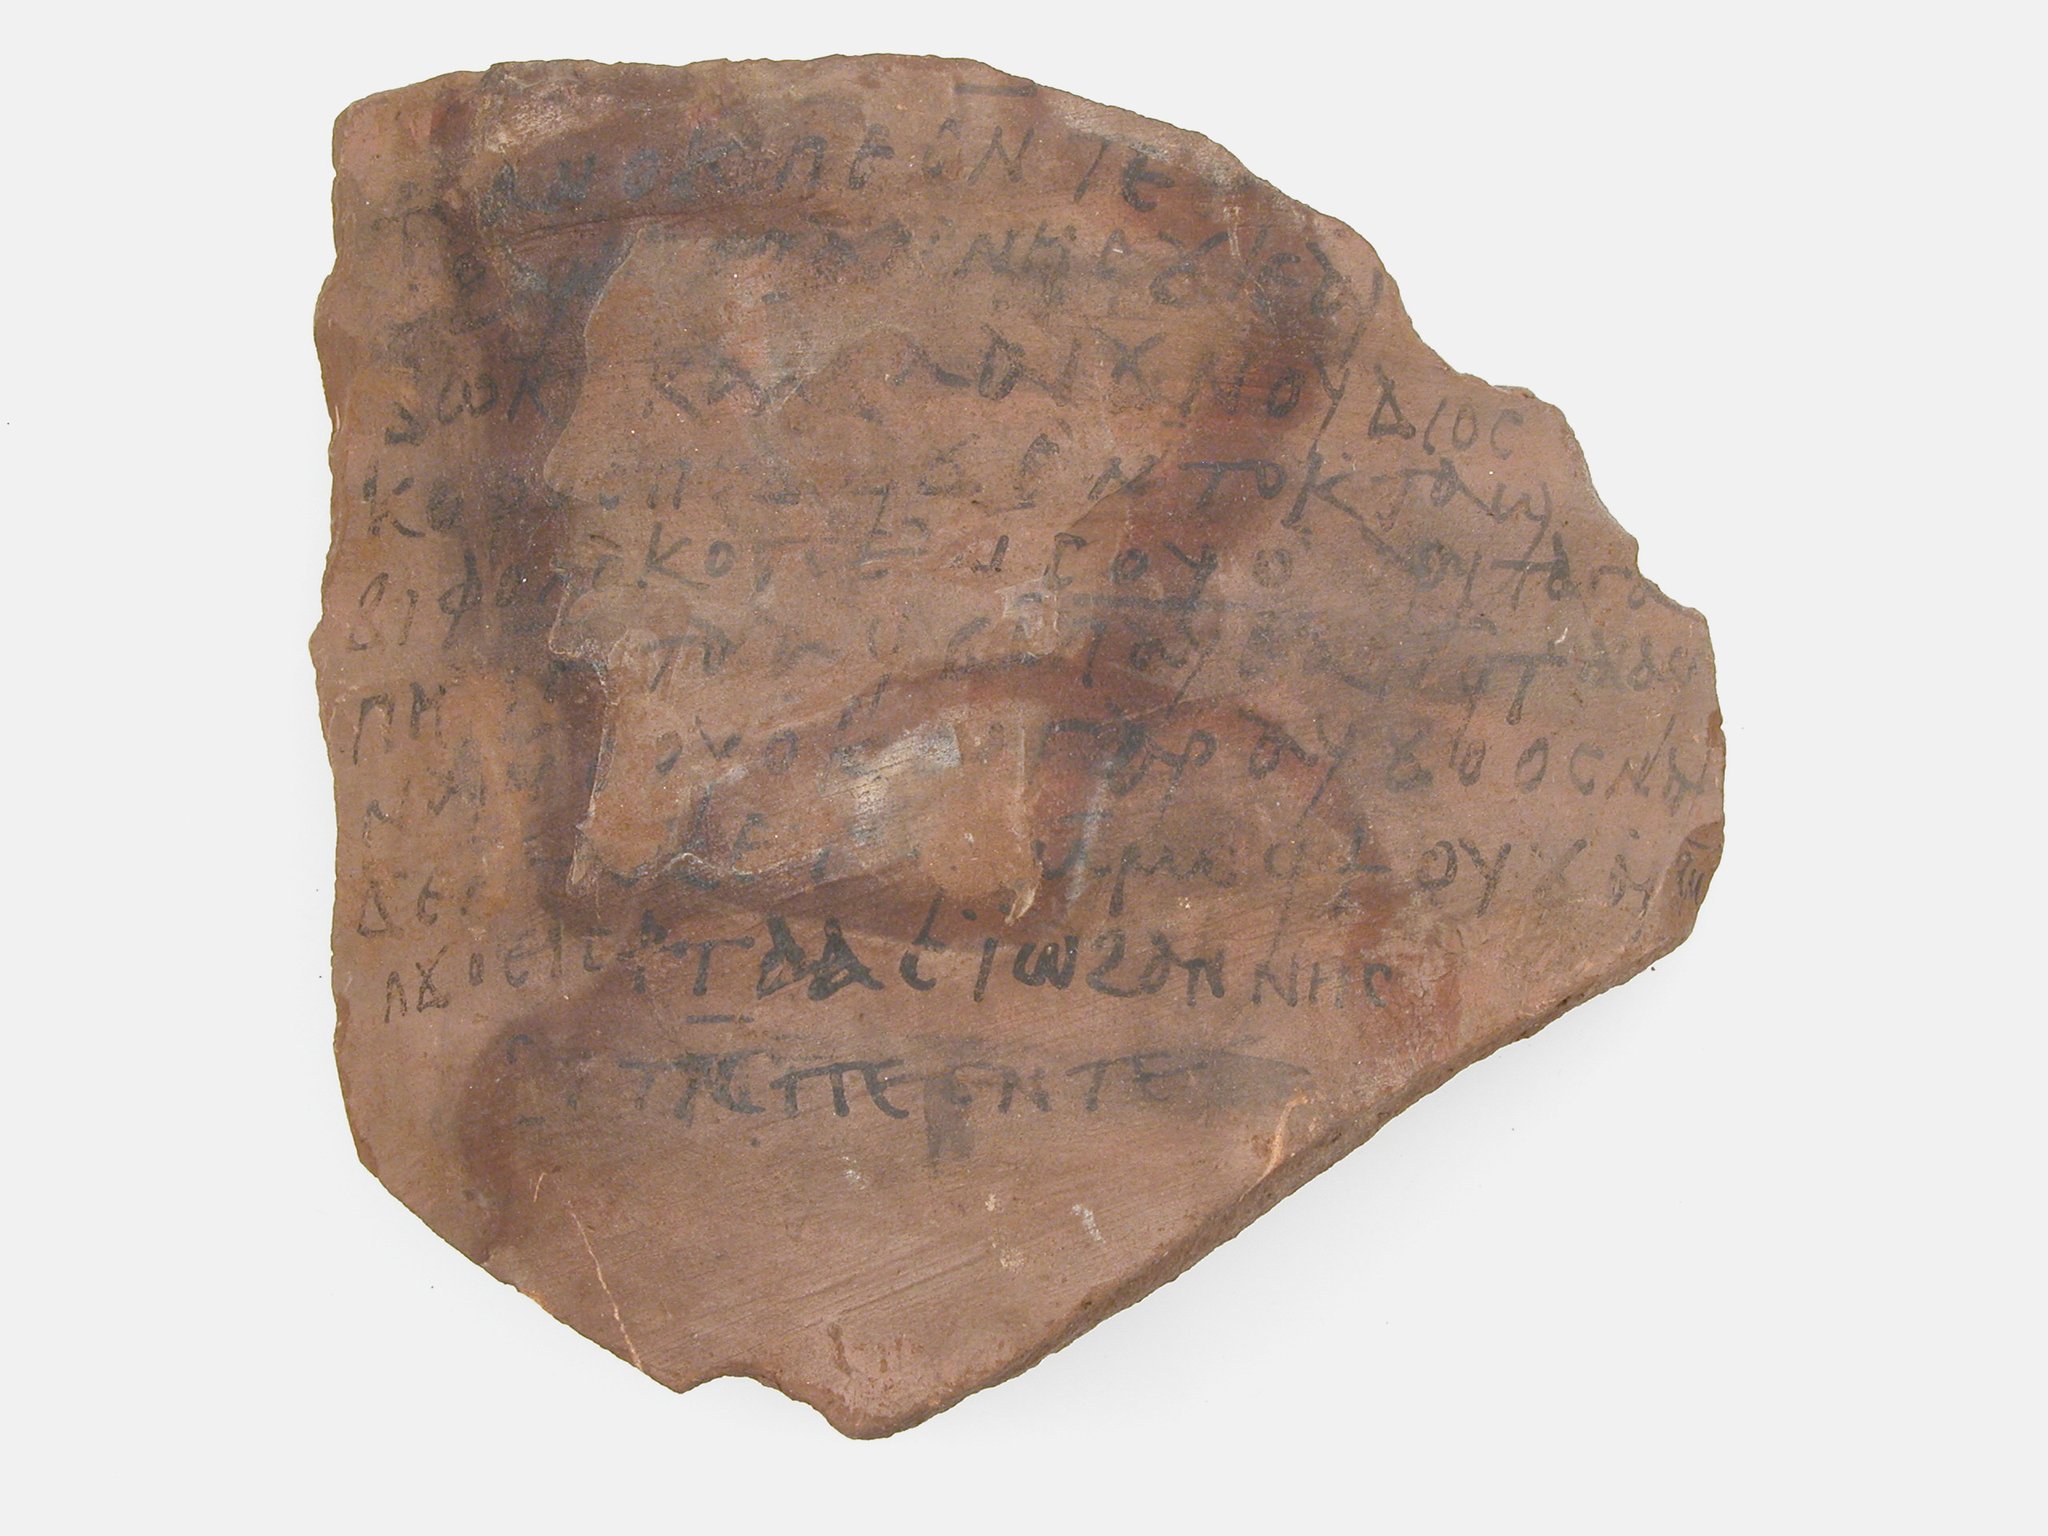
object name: ostrakon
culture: coptic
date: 601-700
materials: ink, pottery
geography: egypt